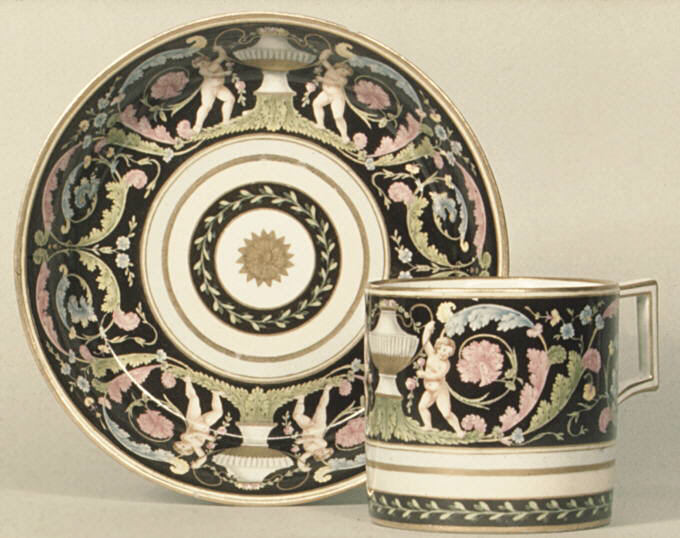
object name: cup and saucer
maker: imperial porcelain manufactory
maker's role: manufactory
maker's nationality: austrian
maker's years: 1744-1864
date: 1788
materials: hard paste porcelain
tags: putti